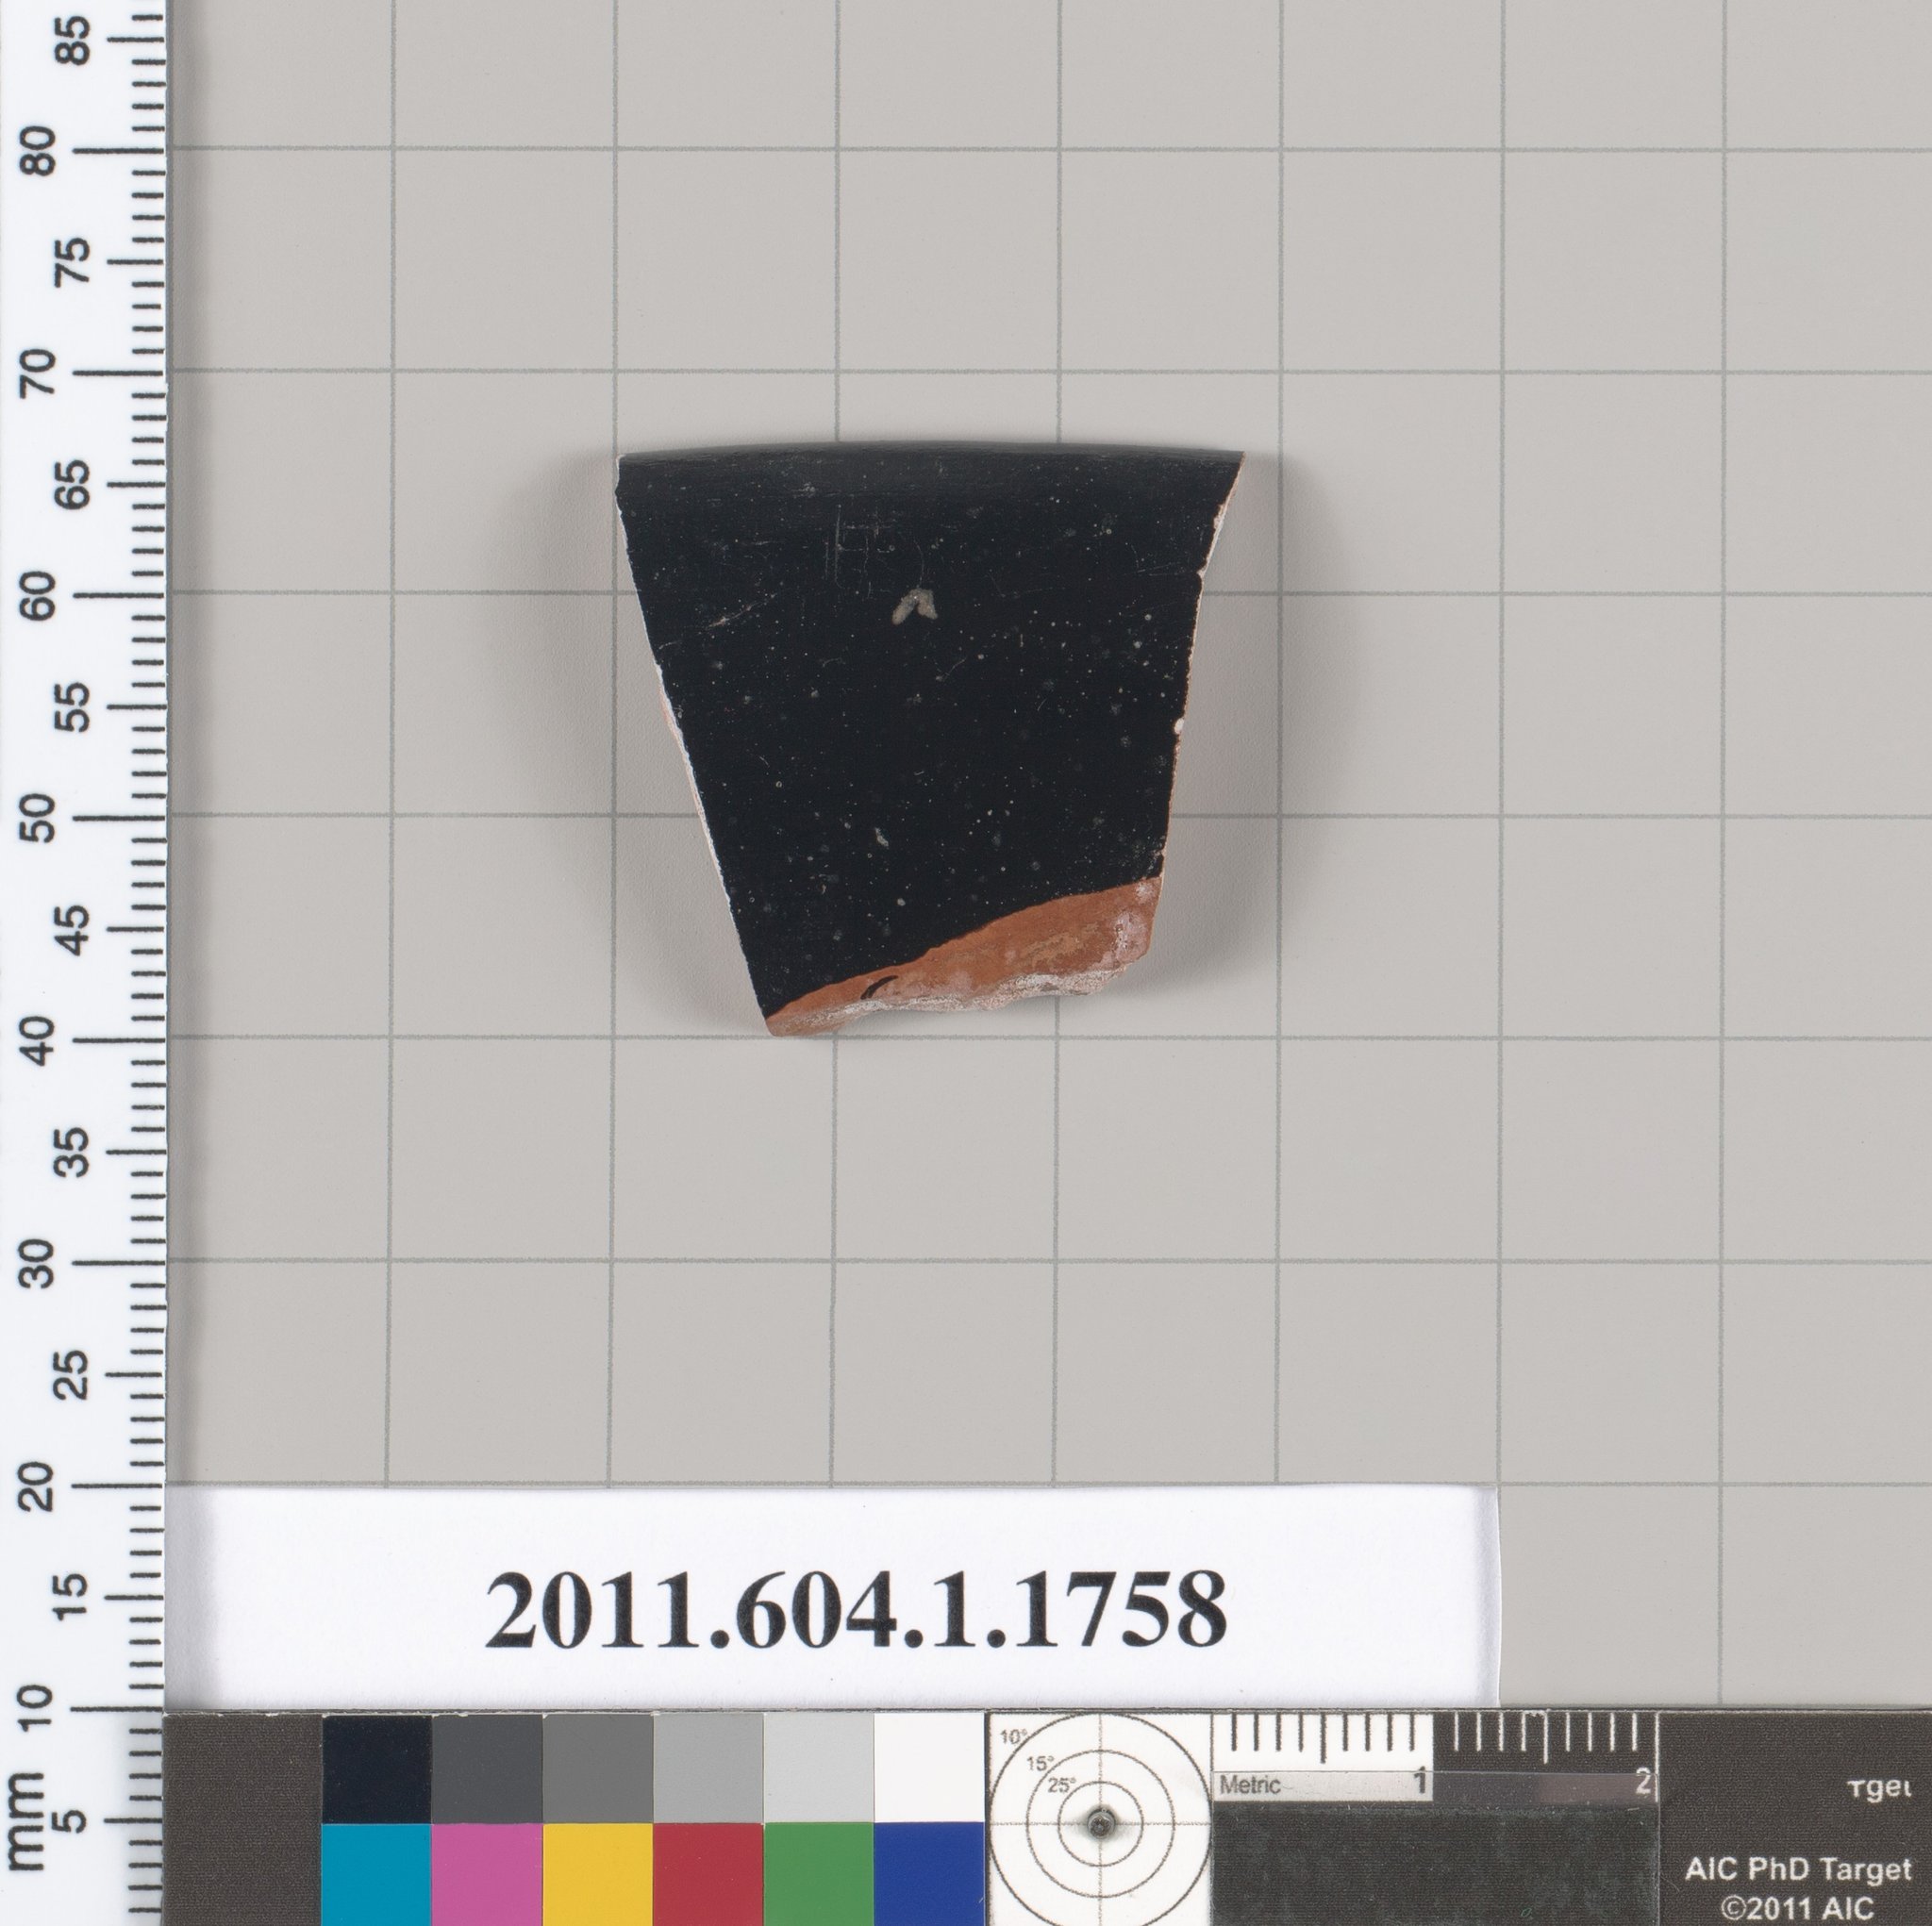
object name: kylix fragment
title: Terracotta rim fragment of a kylix (drinking cup)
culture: greek, attic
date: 475-451 BCE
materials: terracotta